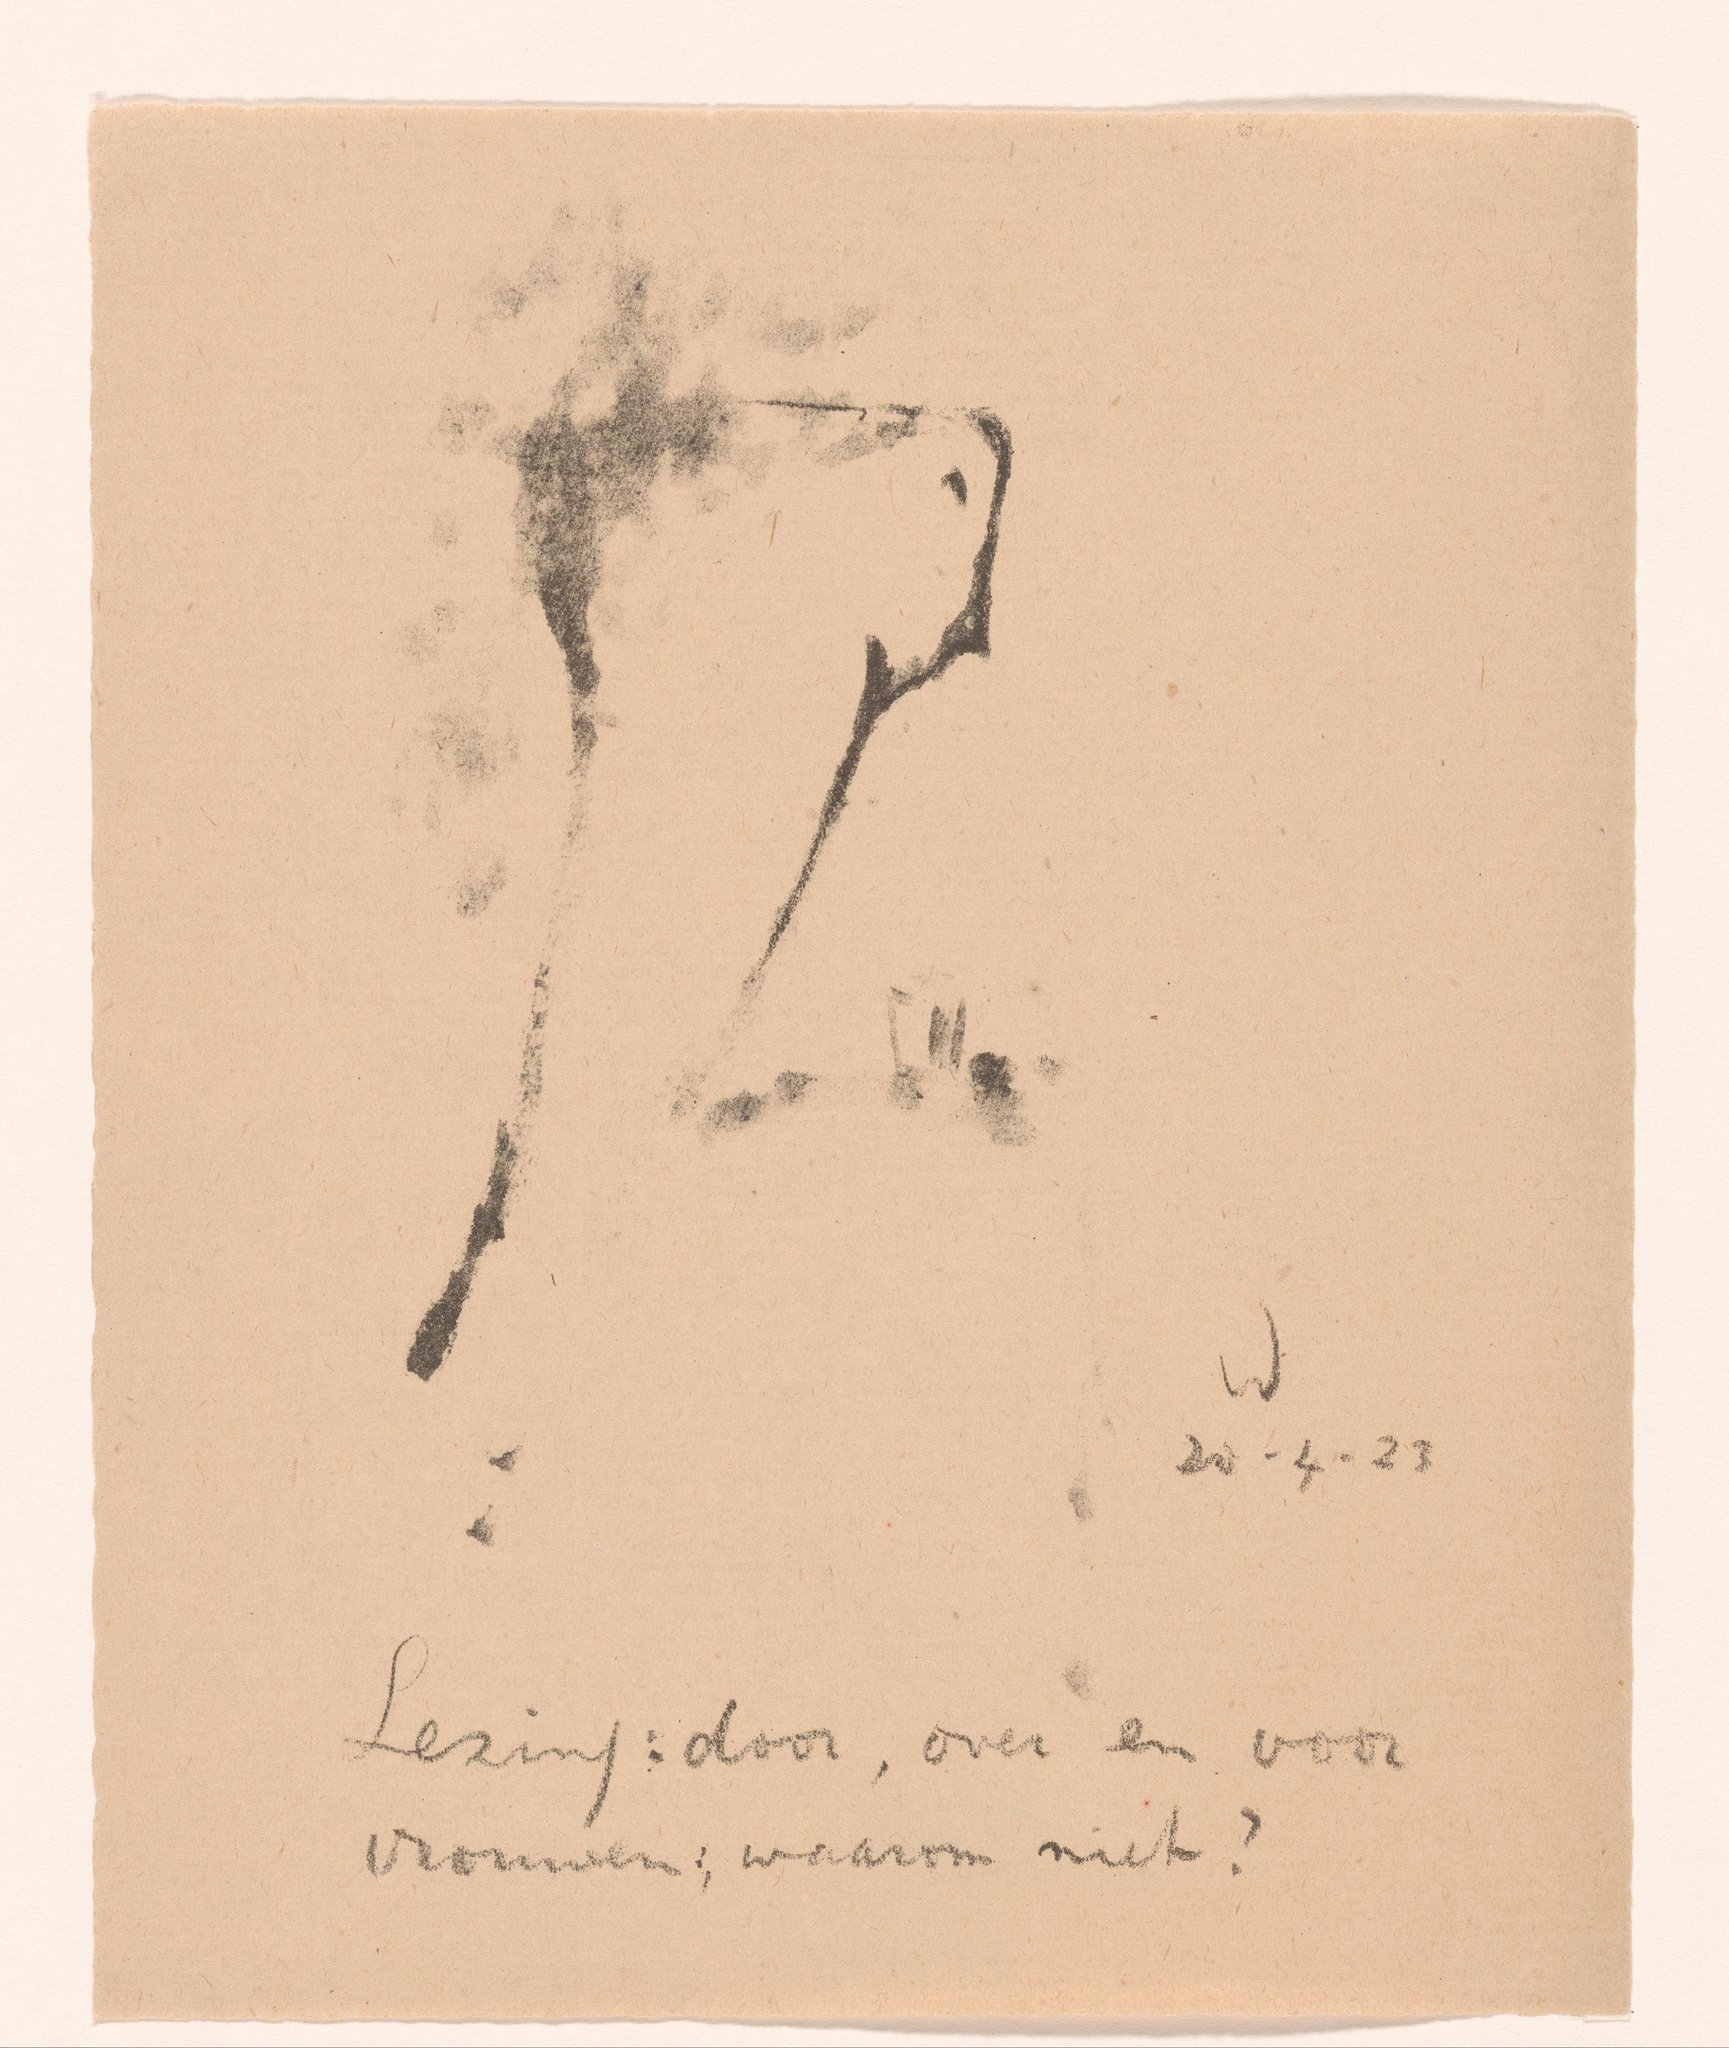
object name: print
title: Idealisten II en verdere Kanttekeningen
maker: erich wichmann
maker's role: print maker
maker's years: 1890-1929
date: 1923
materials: paper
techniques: lithograph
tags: caricatures (human types)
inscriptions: collector's mark: Lugt 2228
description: Onderaan de tekst: 'Lezing: door, over en voor vrouwen: waarom niet?'